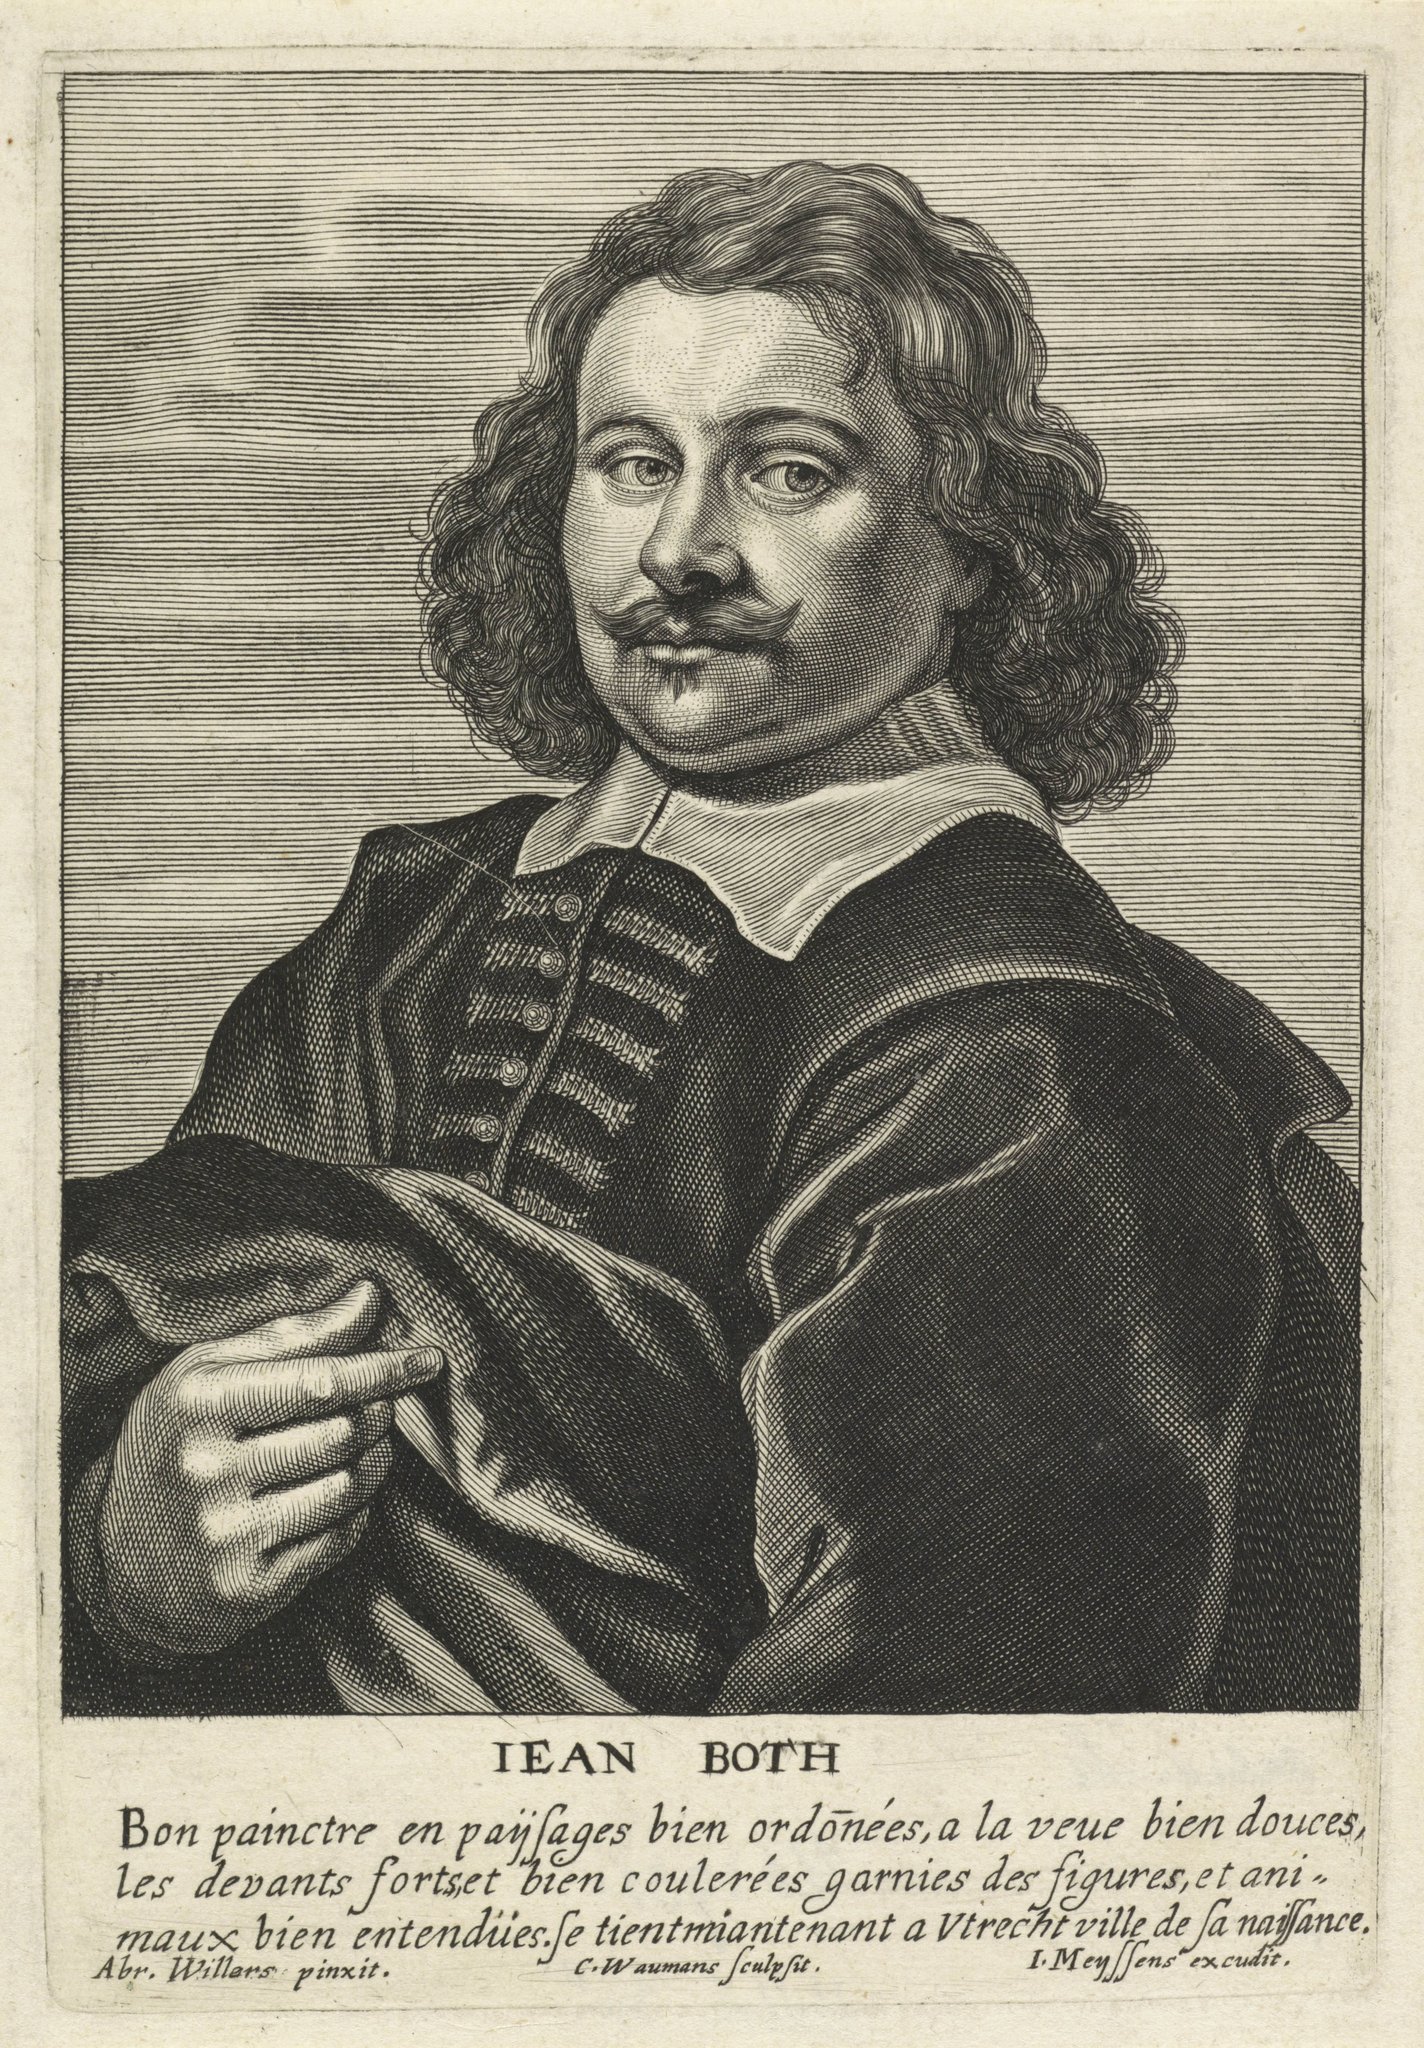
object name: print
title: Portret van de schilder Jan Both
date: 1662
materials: paper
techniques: engraving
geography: antwerp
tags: painter, print maker, draughtsman, jan both, portrait, self-portrait of painter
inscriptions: collector's mark: Lugt 2760, collector's mark: Lugt 2228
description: Portret van de schilder Jan Both. In de marge de naam van de geportretteerde en een drieregelig onderschrift met biografische gegevens in het Frans.